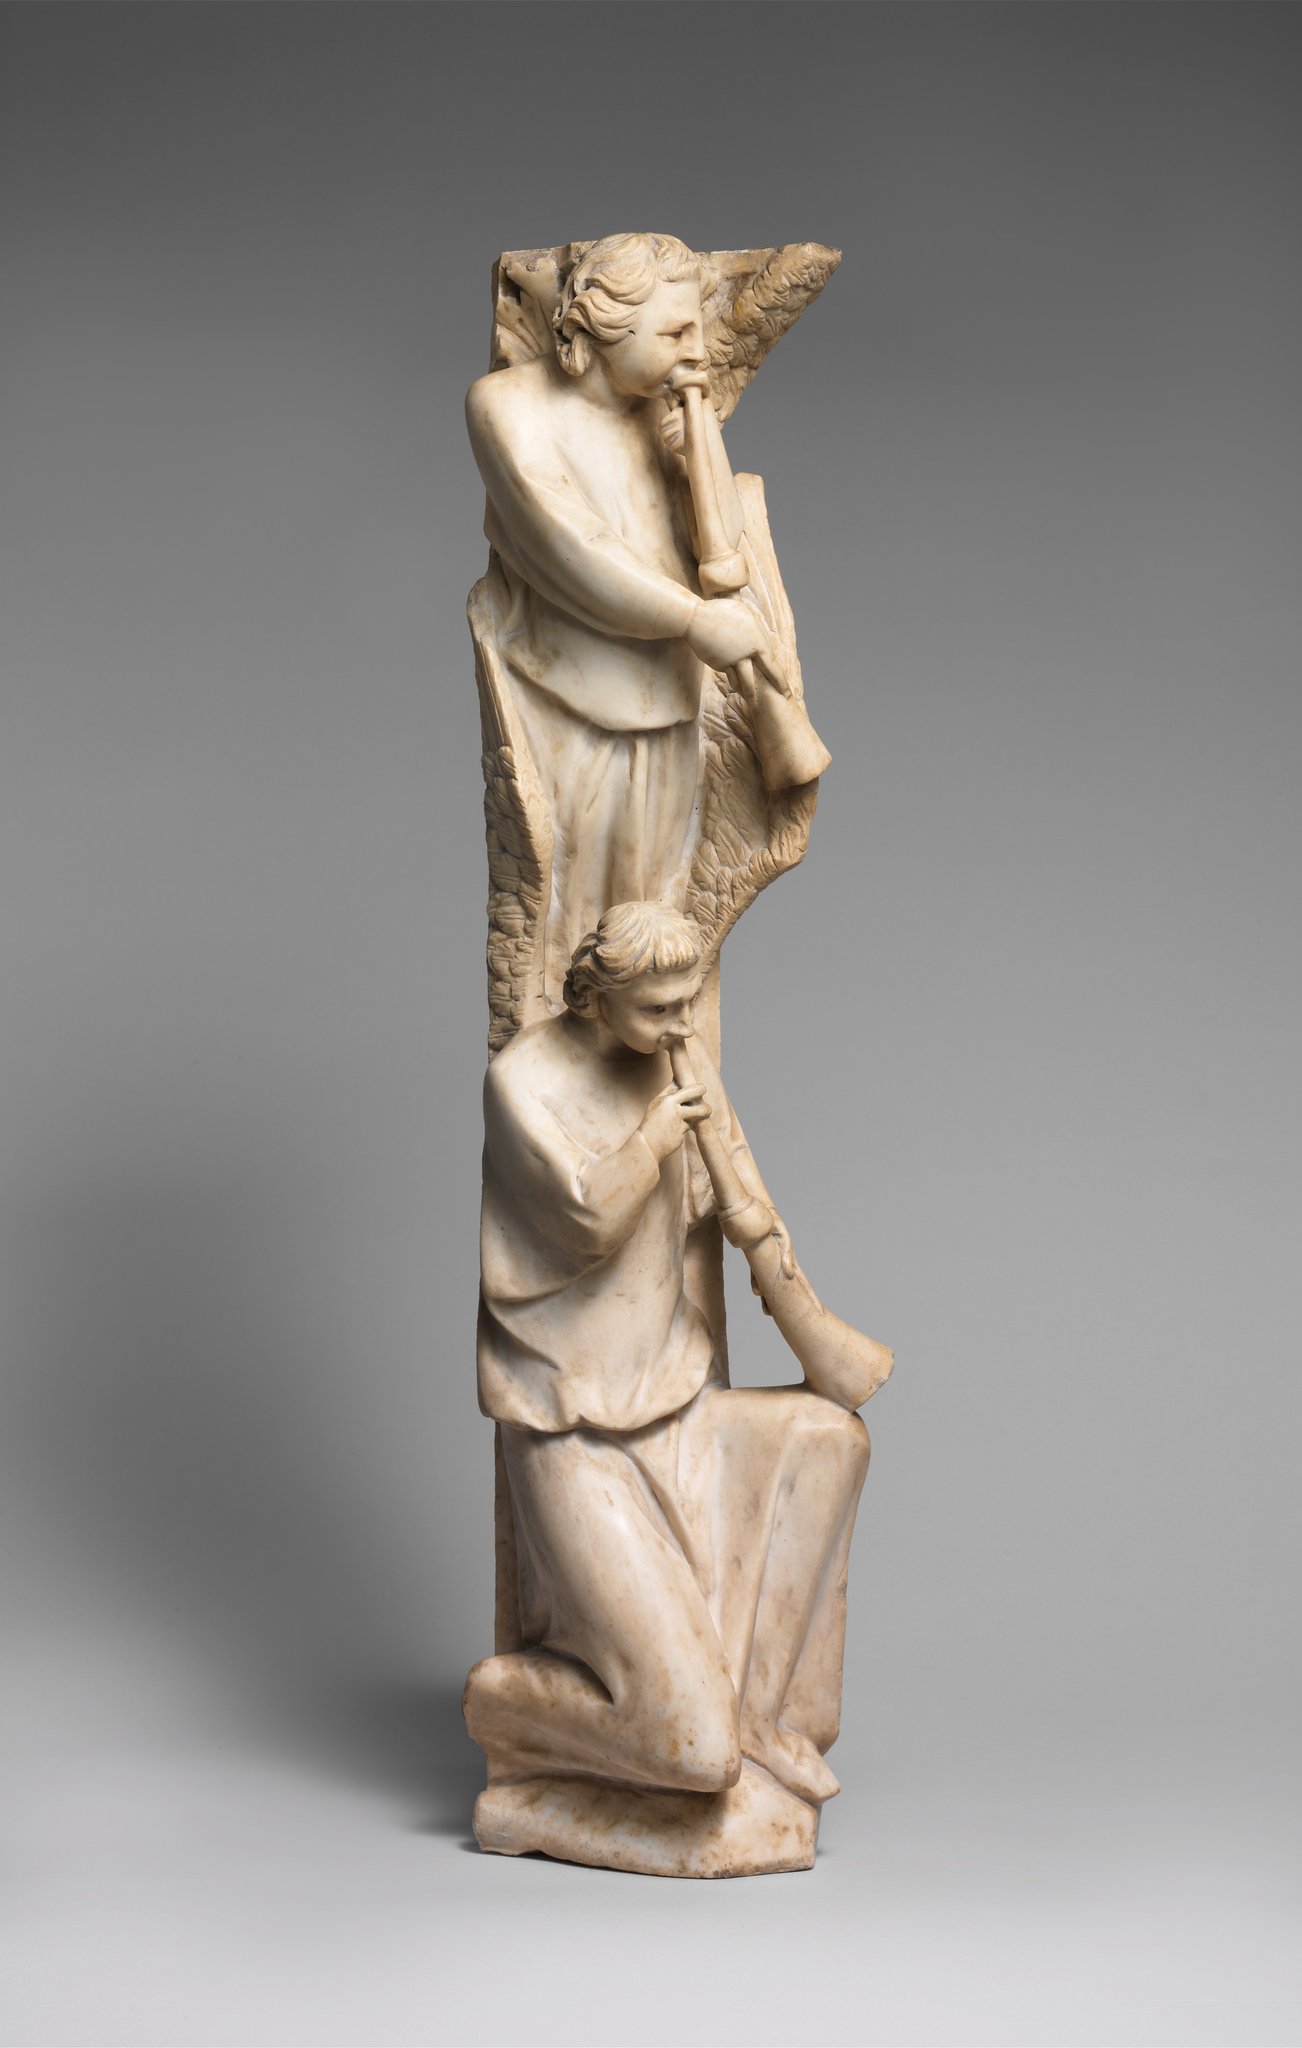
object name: pilaster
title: Pilaster of Angels Sounding Trumpets from the Parapet of a Pulpit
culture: central italian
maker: giovanni pisano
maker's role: artist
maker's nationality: italian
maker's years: 1235-1320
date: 1302-1310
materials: marble, paint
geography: italy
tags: trumpets,angels